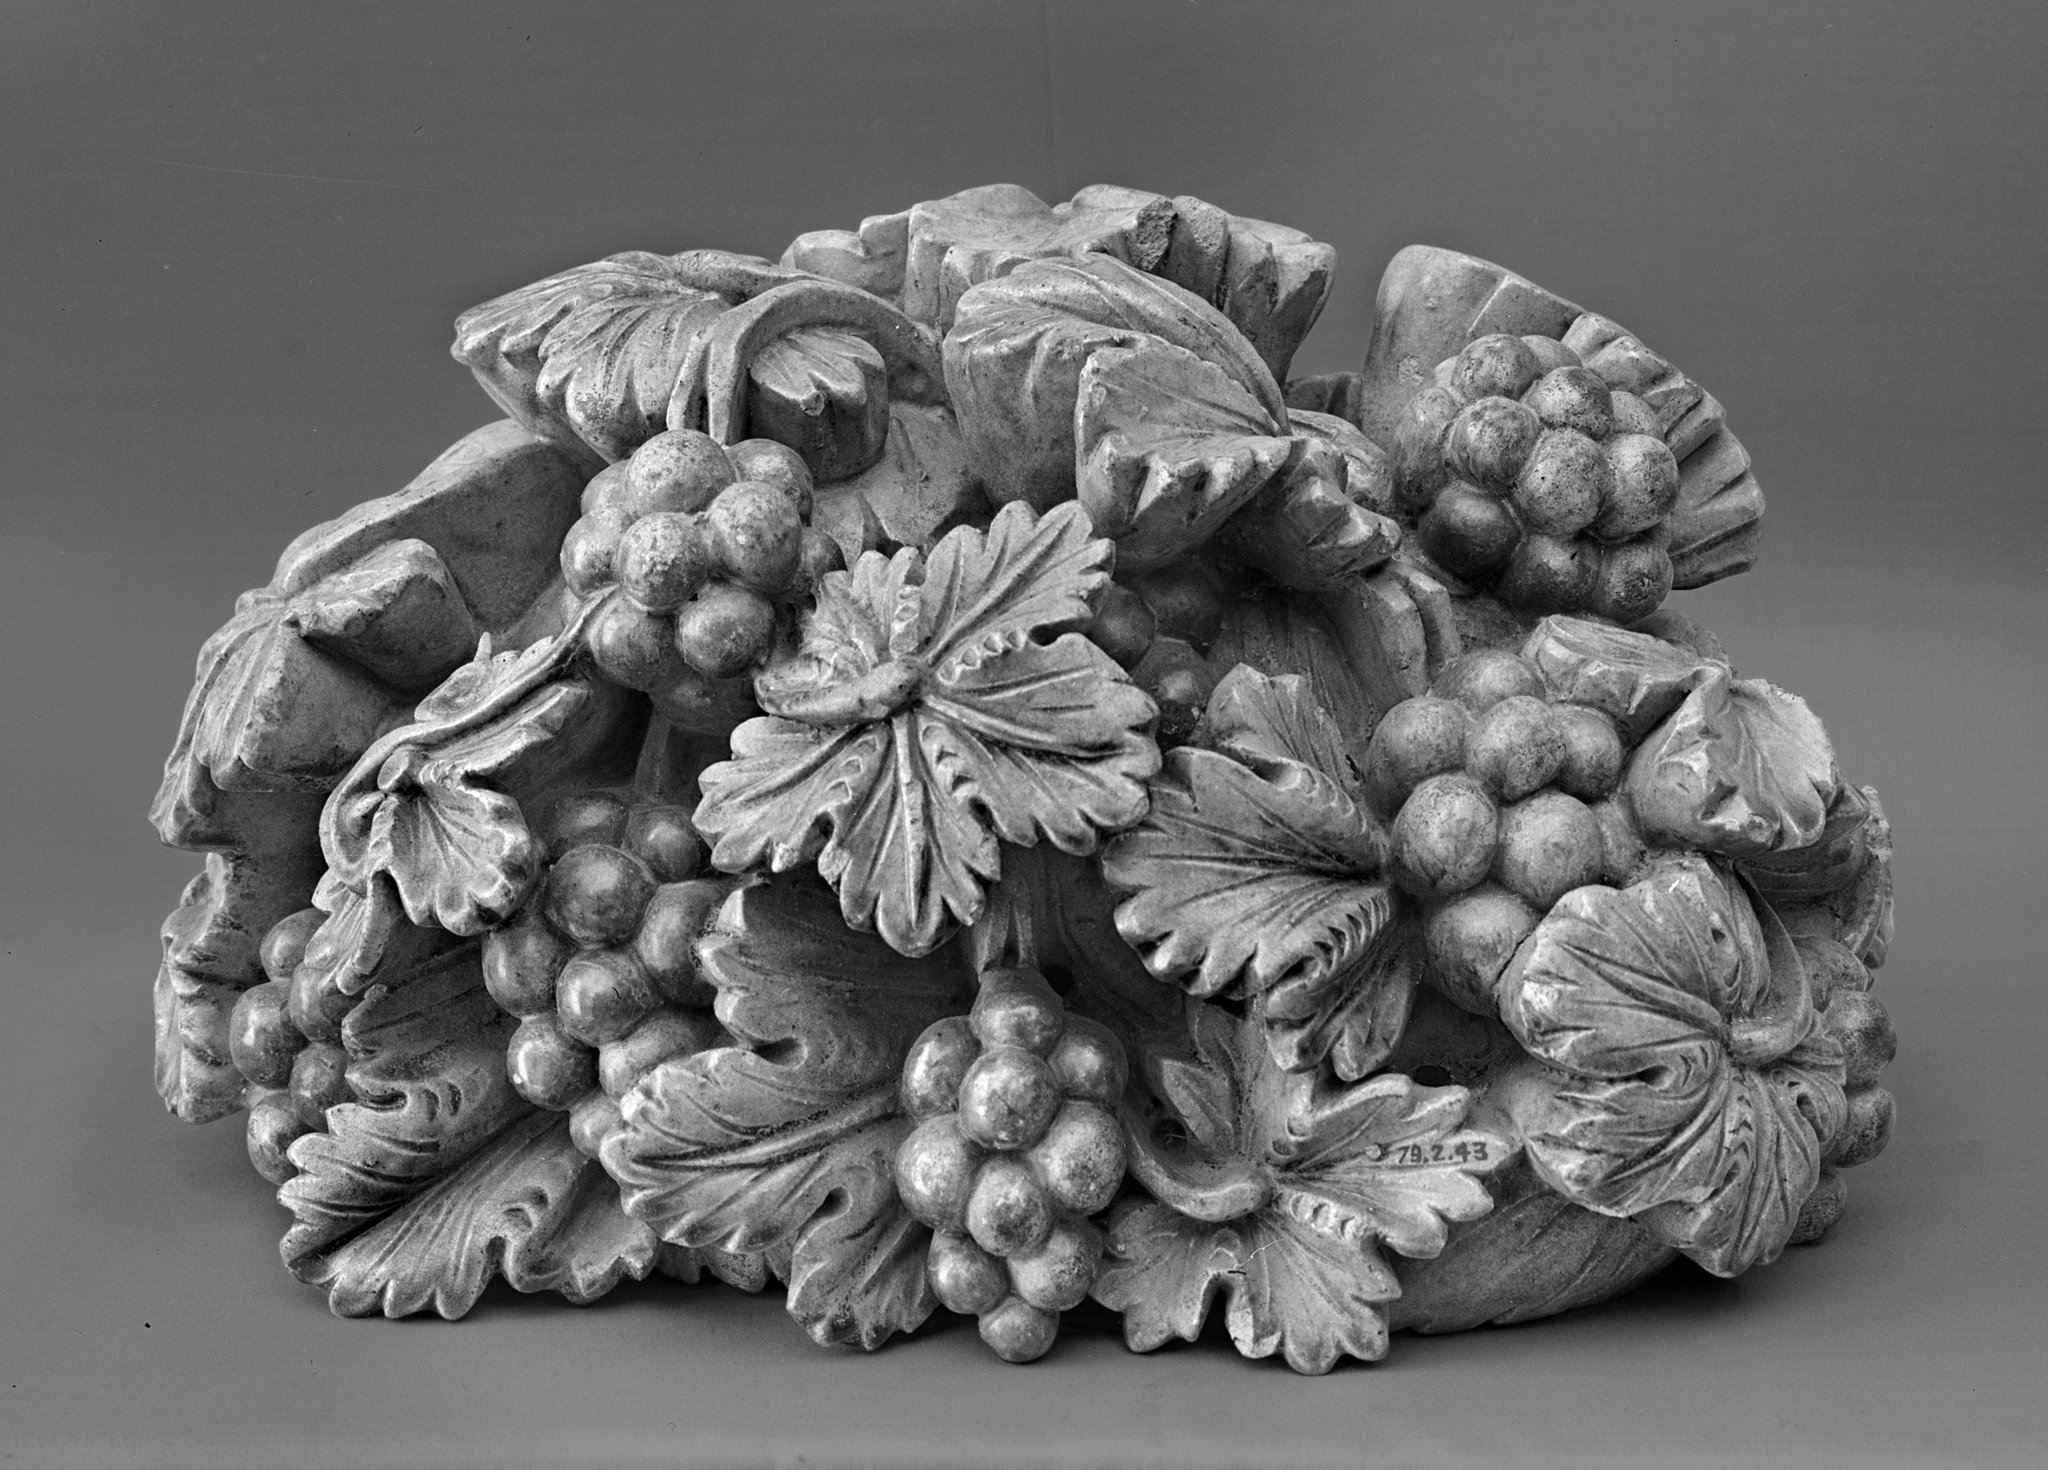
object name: architectural tile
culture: chinese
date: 1644-1911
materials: glaze, stoneware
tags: grapes,leaves